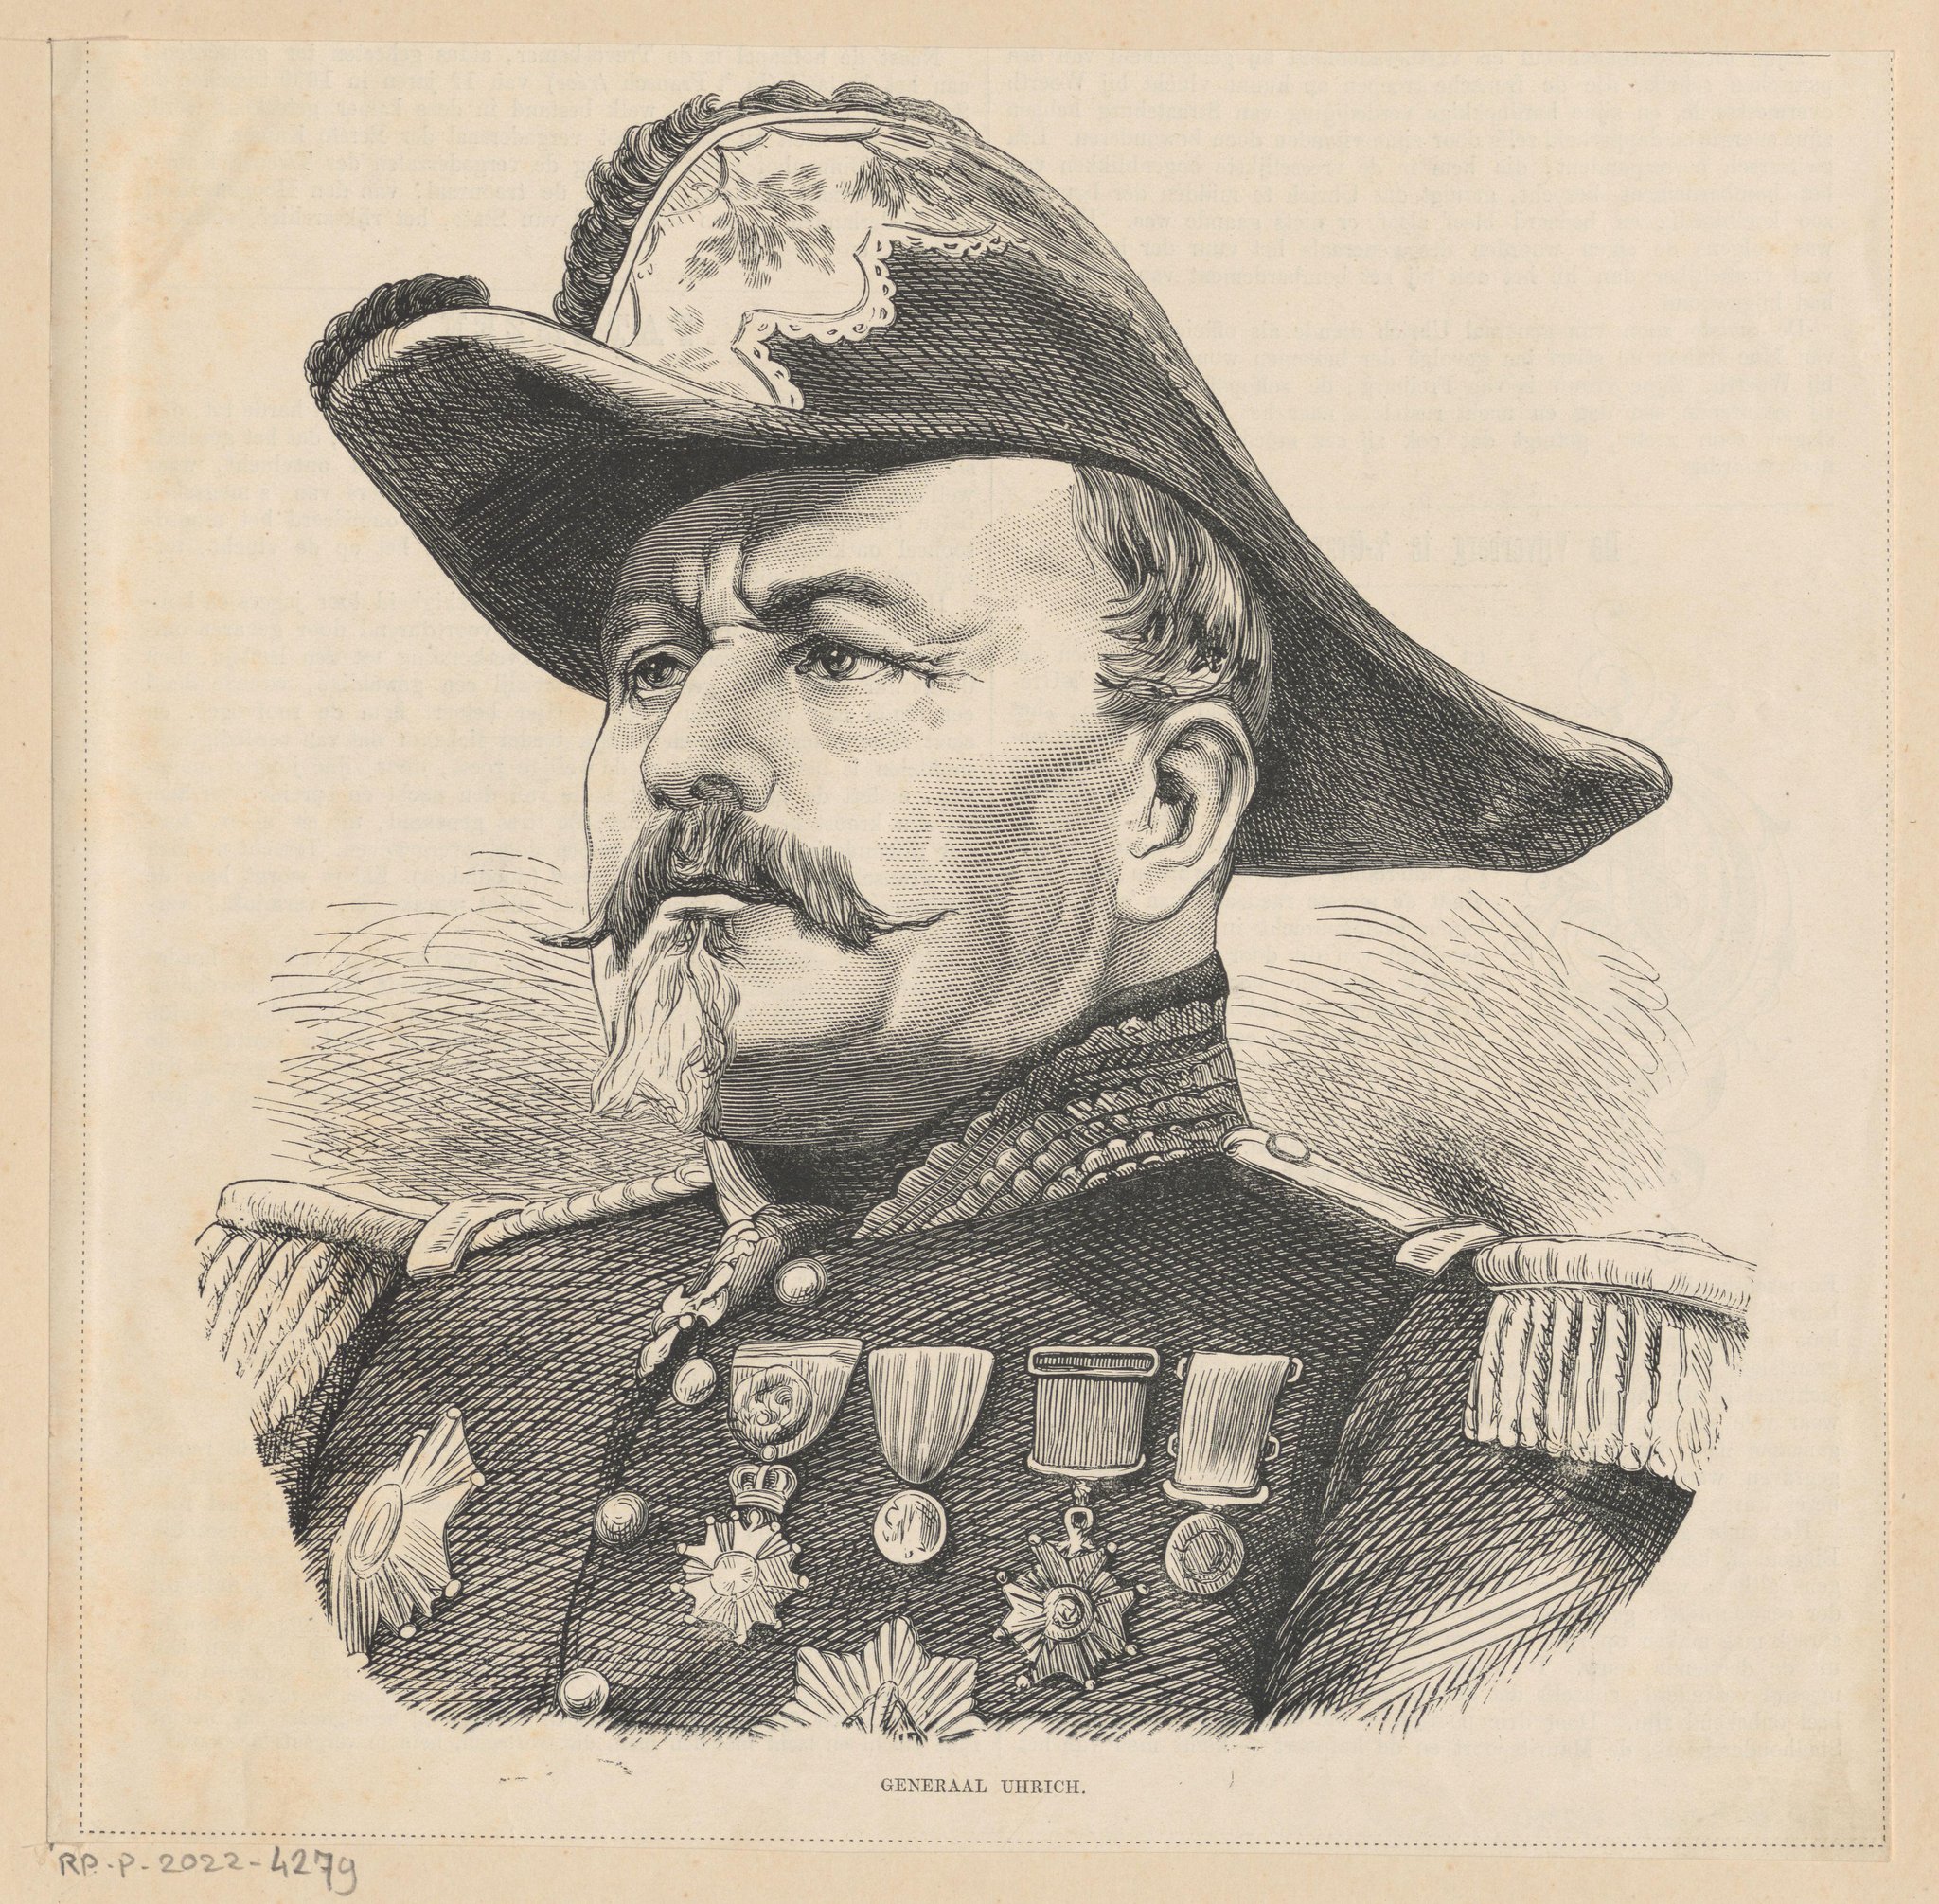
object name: book illustration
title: Portret van Jean-Jacques Uhrich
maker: Anonymous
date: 1870-1920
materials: paper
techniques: letterpress printing, engraving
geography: netherlands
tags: paris, commander-in-chief, general, marshal, historical persons, medals and other marks of military honour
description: Prent komt uit een onbekende publicatie.